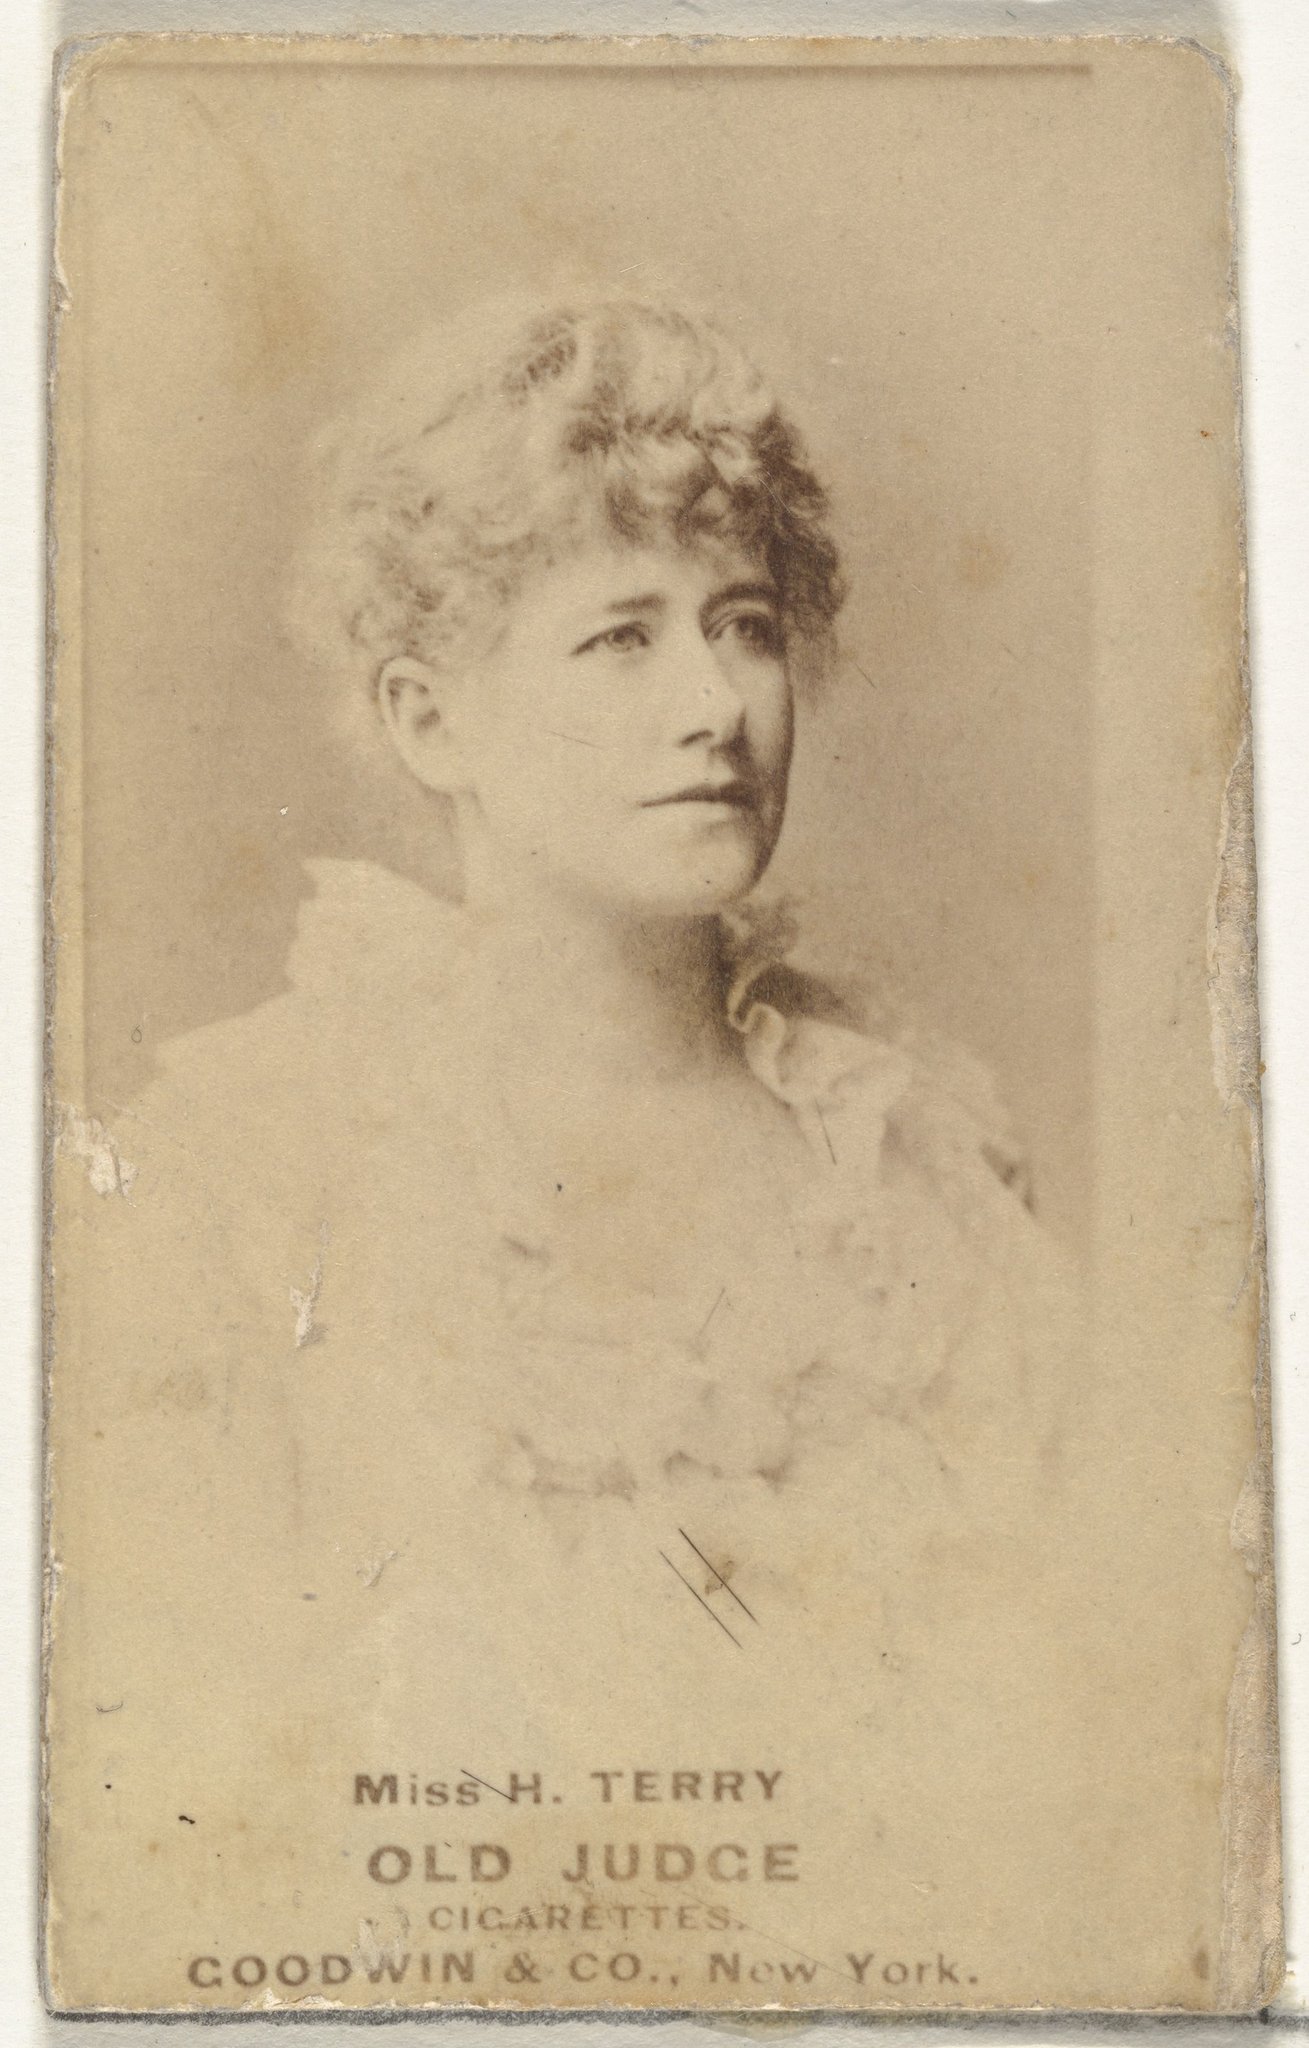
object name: photograph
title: Miss H. Terry, from the Actors and Actresses series (N171) for Old Judge Cigarettes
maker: goodwin & company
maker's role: publisher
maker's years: 1850-1950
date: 1886-1890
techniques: albumen silver print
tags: portraits,women,actresses